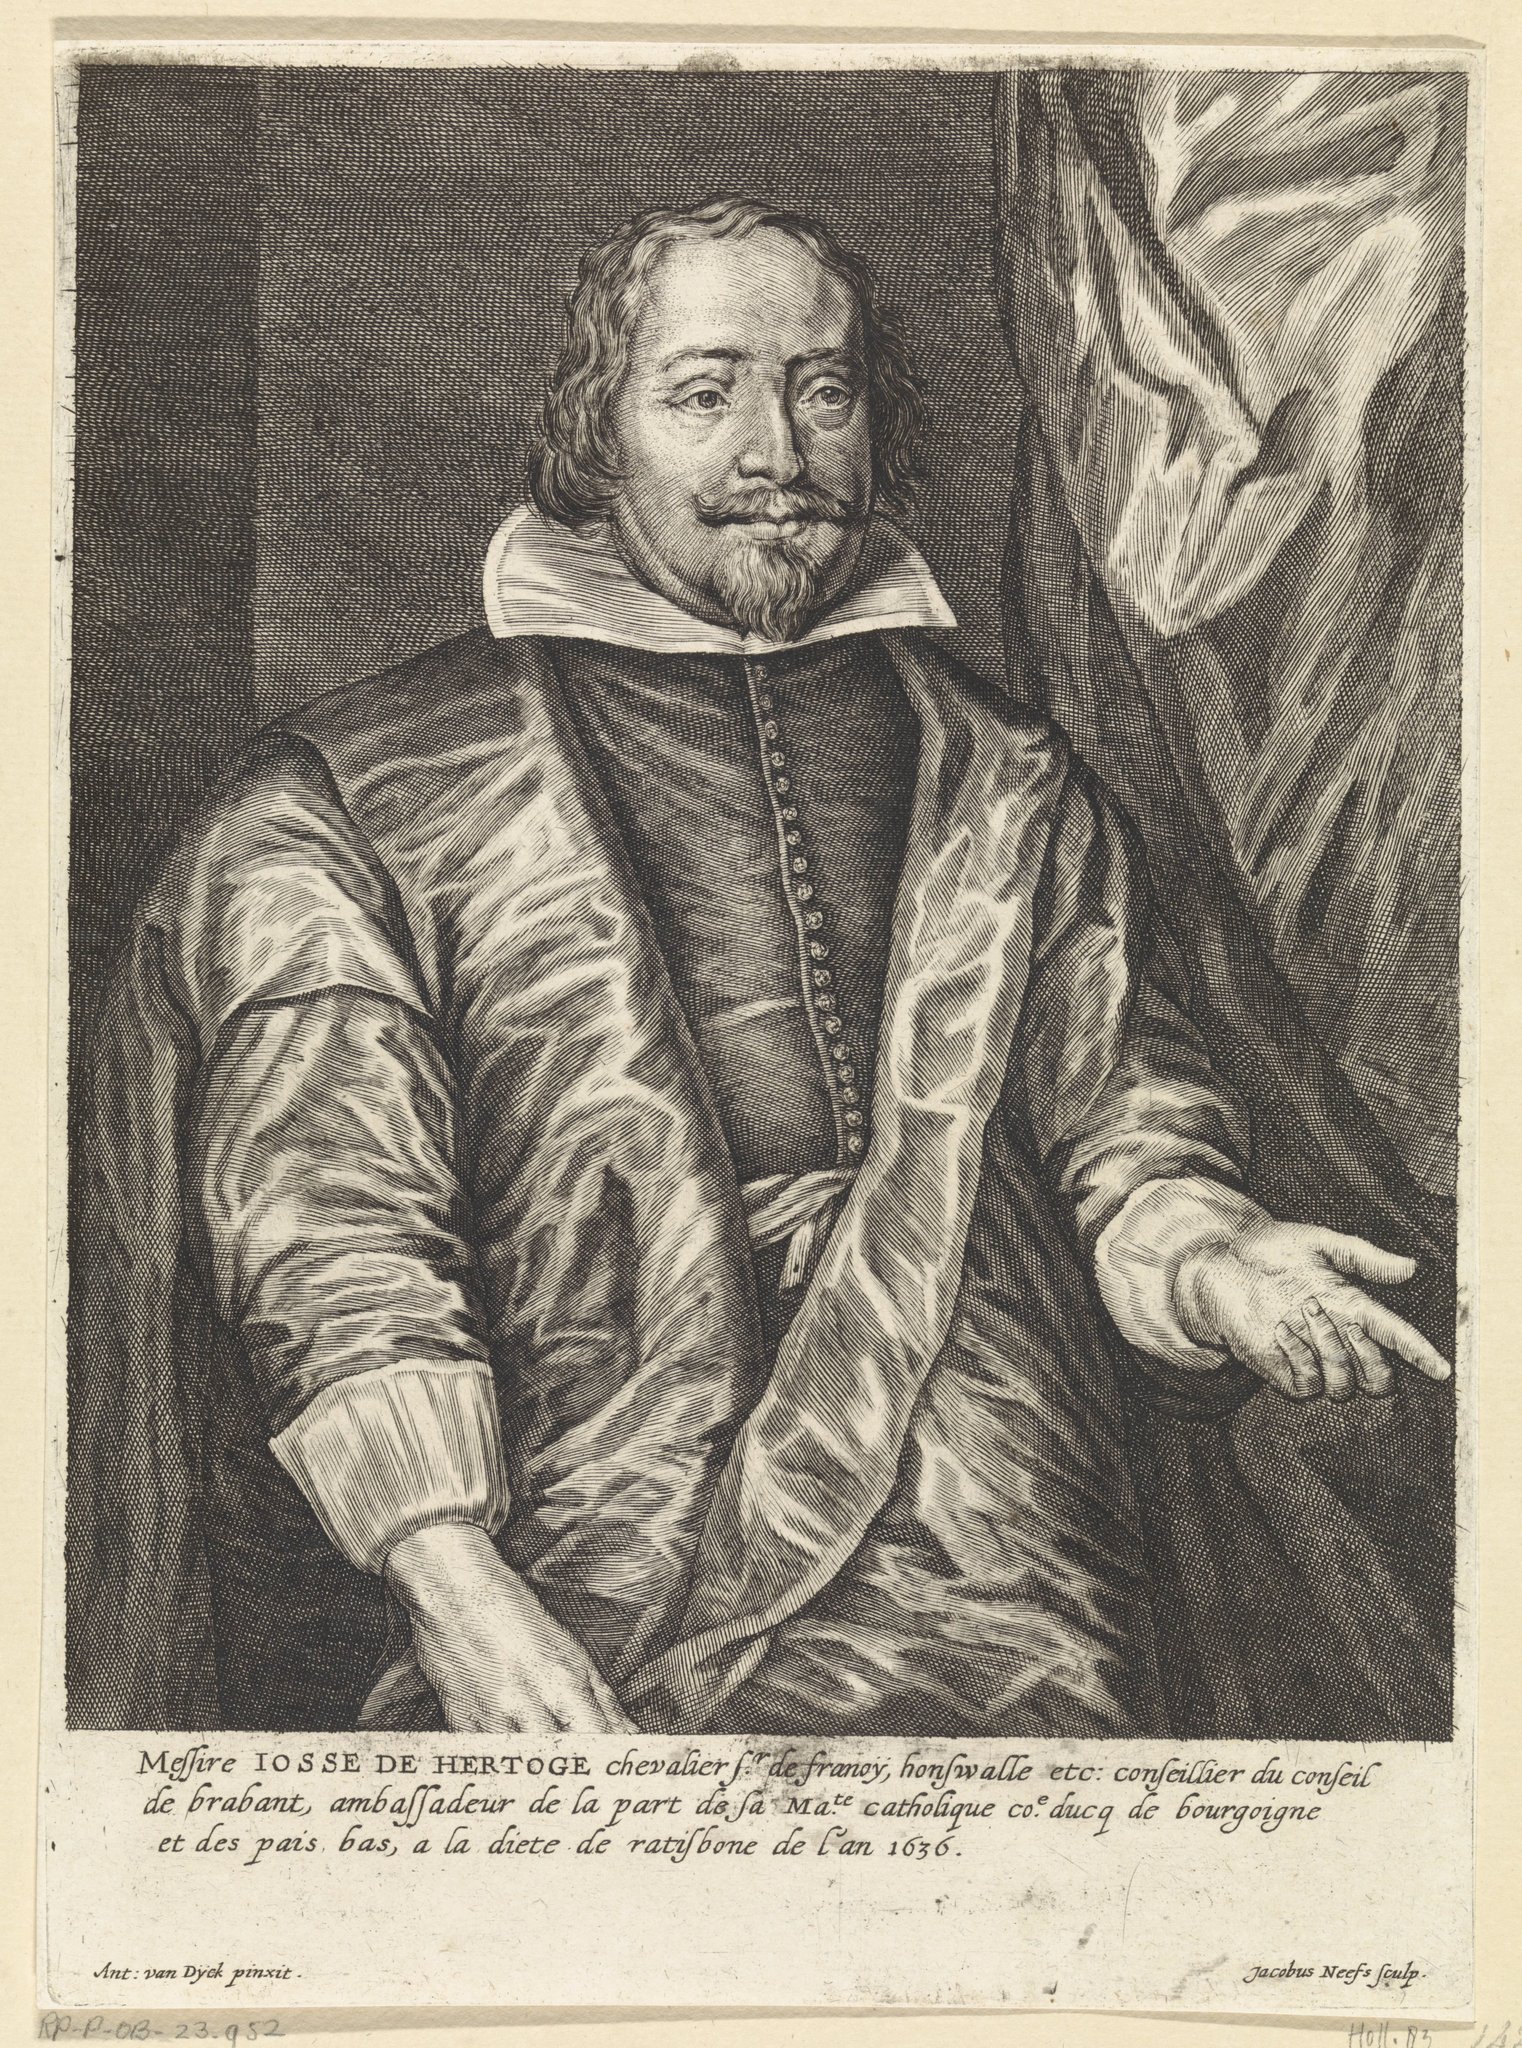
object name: print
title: Portret van Joost de Hertoghe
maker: jacob neefs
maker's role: print maker, publisher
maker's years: 1610-1660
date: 1636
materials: paper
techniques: engraving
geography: antwerp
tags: raadsheer, joost de hertoghe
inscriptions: collector's mark: Lugt 240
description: Joost de Hertoghe, raadsheer van het Hof van Brabant, staand voor een gordijn. Portret ten halven lijve naar rechts. Onderaan in de marge een drieregelige tekst in het Frans.